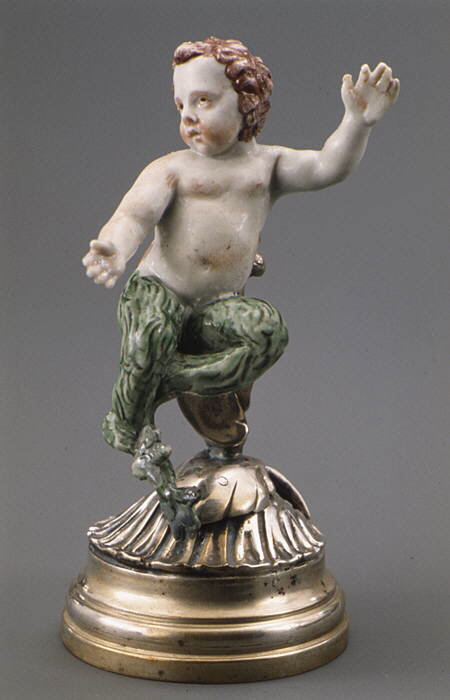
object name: figure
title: Child (one of six)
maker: doccia porcelain manufactory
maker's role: manufactory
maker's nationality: italian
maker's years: 1737-1896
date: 1750-1755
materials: hard paste porcelain, silver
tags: children